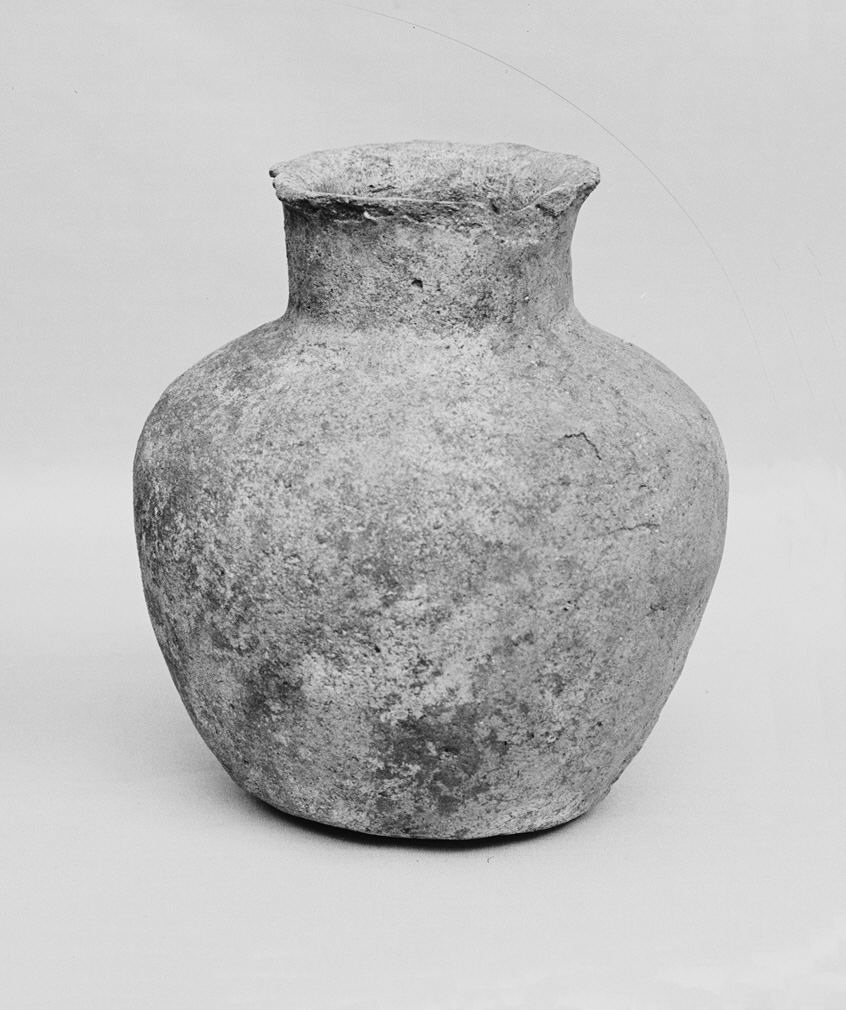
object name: jug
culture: japanese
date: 1912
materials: earthenware